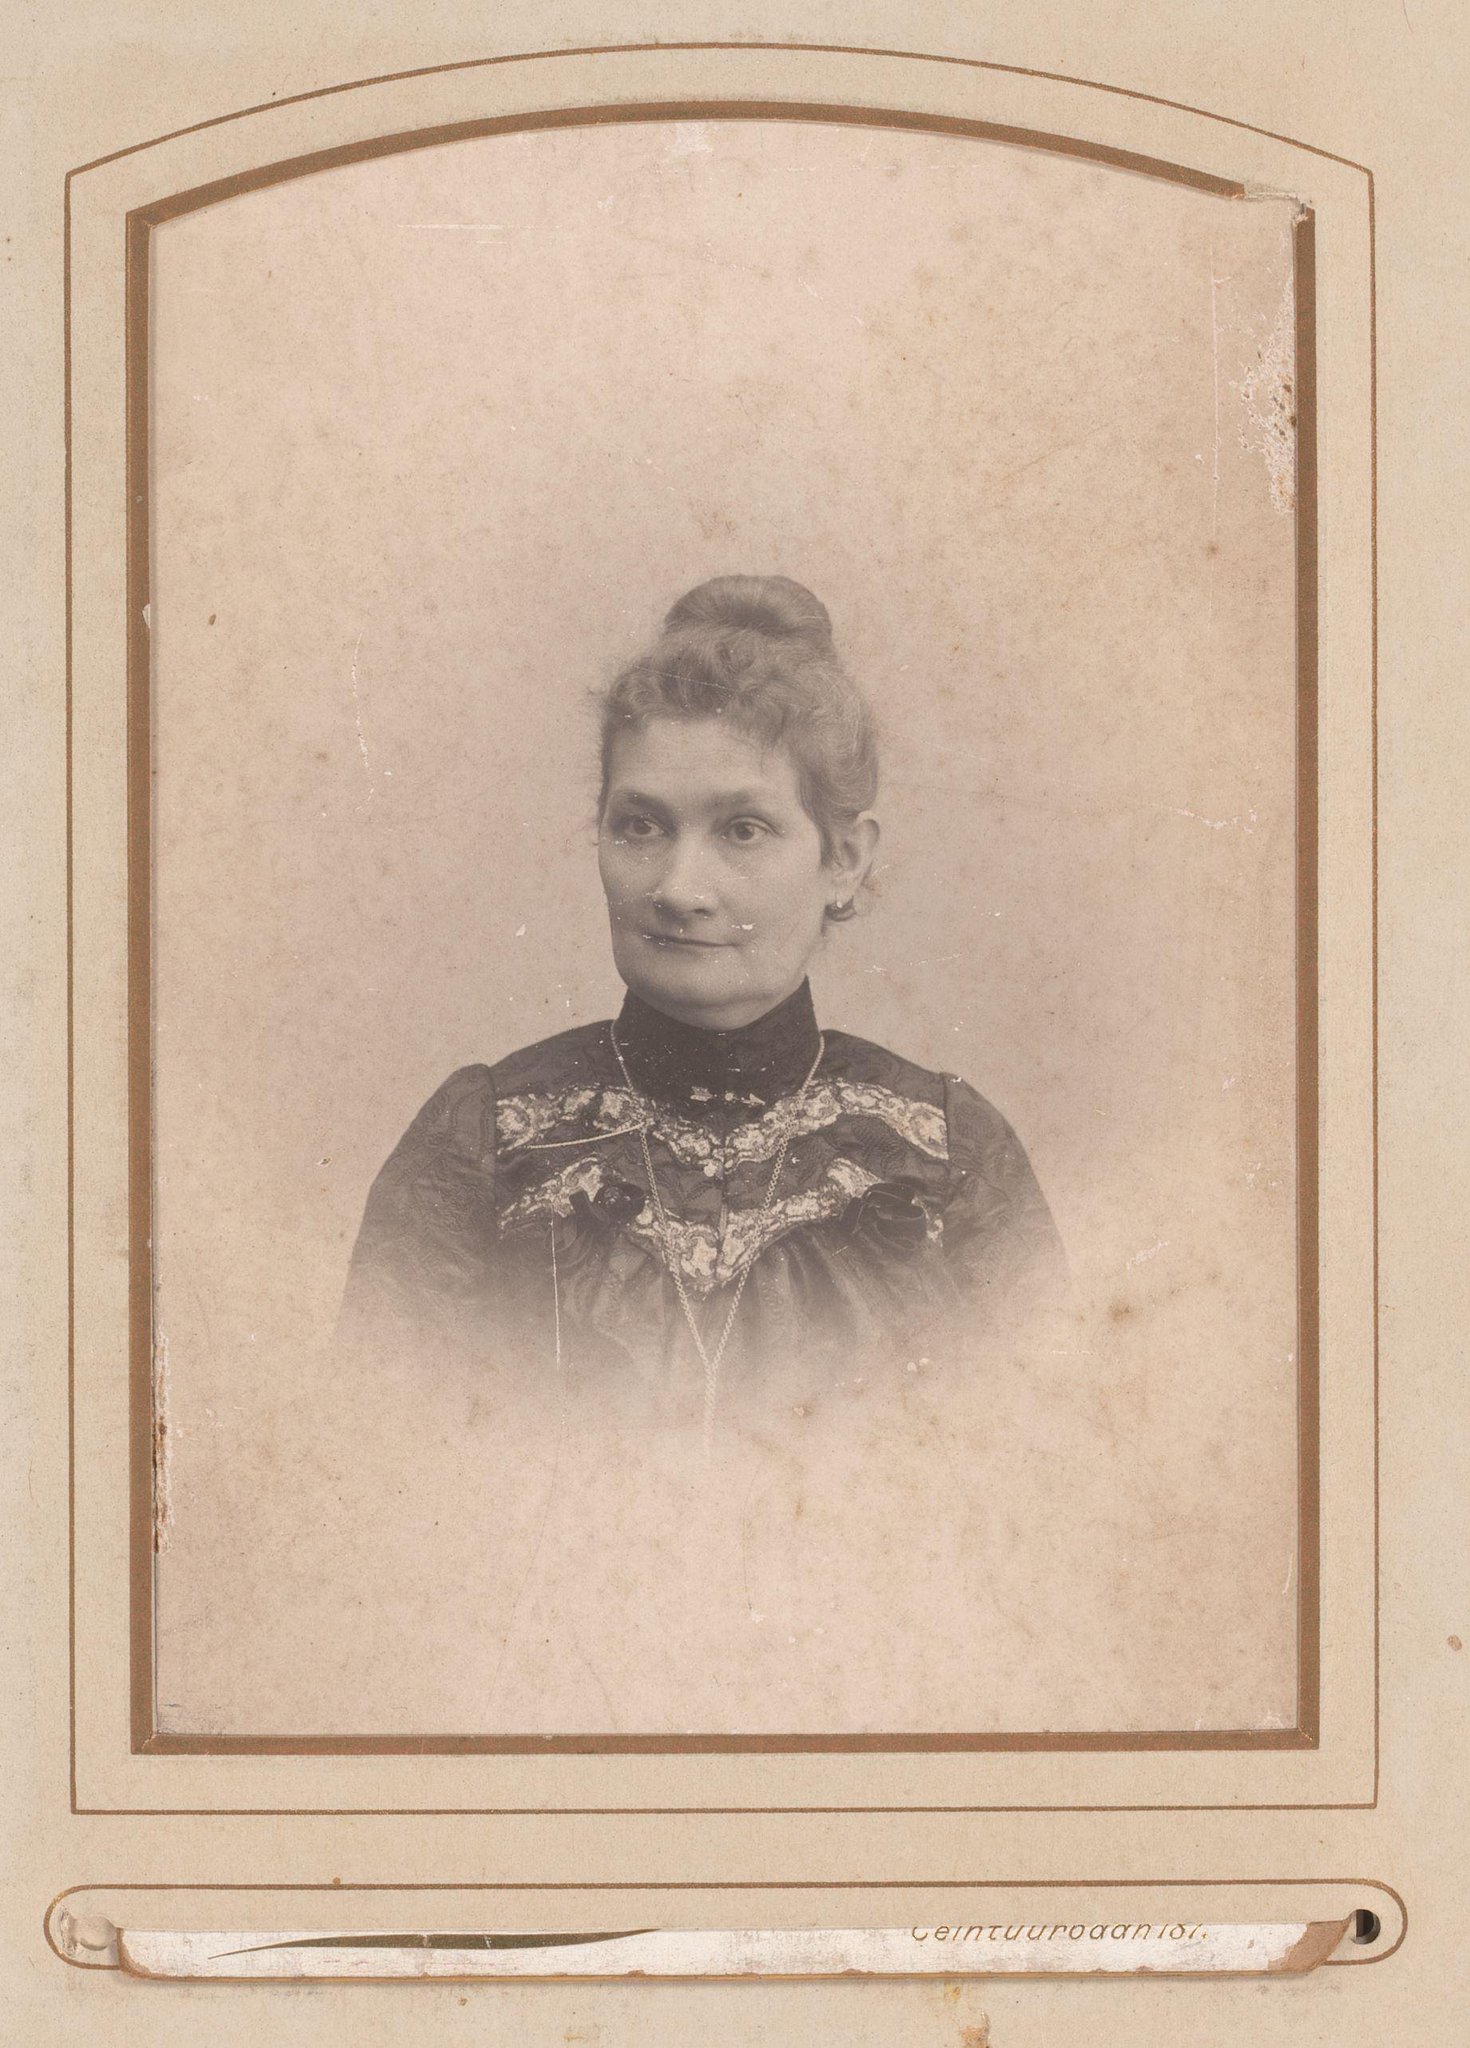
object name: album leaf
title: Portret van een vrouw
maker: franciscus g. lukera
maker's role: fotograaf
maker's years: 1853-1927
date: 1880-1910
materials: cardboard, photographic support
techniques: collodion silver print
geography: amsterdam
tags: historical persons - bb - woman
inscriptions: inscription: ‘F. Lukera/ Amsterdam/ Ceintuurbaan 187’